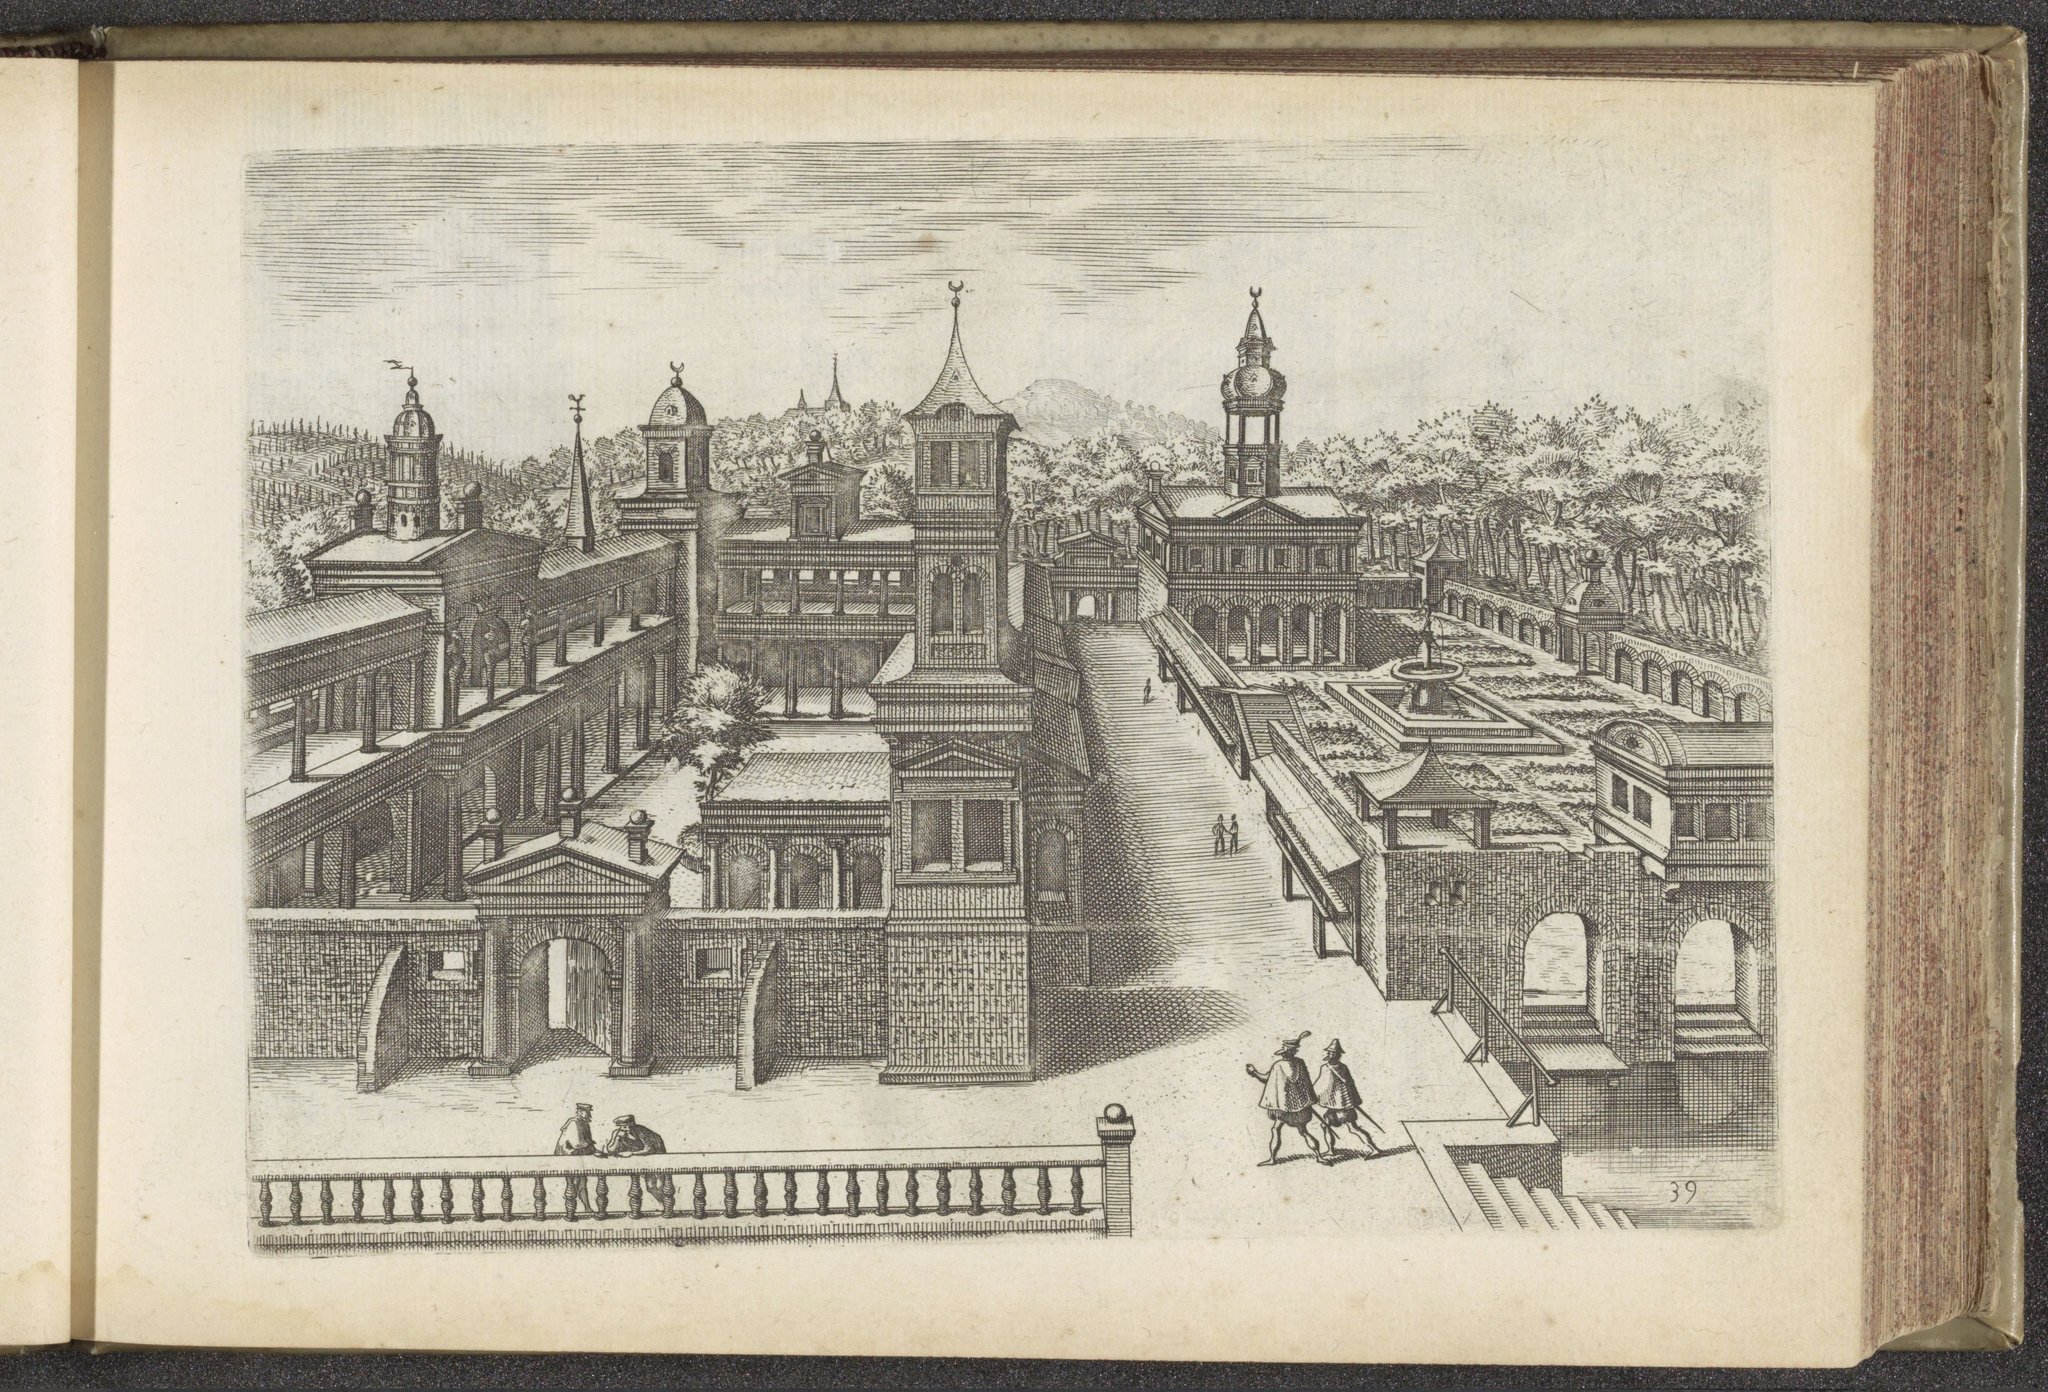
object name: album leaf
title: Variae Architecturae formae (...)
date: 1562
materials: paper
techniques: etching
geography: antwerp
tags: architectural representations in general, courtyard, ornamental fountain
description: Gezicht op een paleis met binnenplaats links en een tuin met fontein rechts. Op de voorgrond twee wandelaars. Deze prent maakt deel uit van een album.